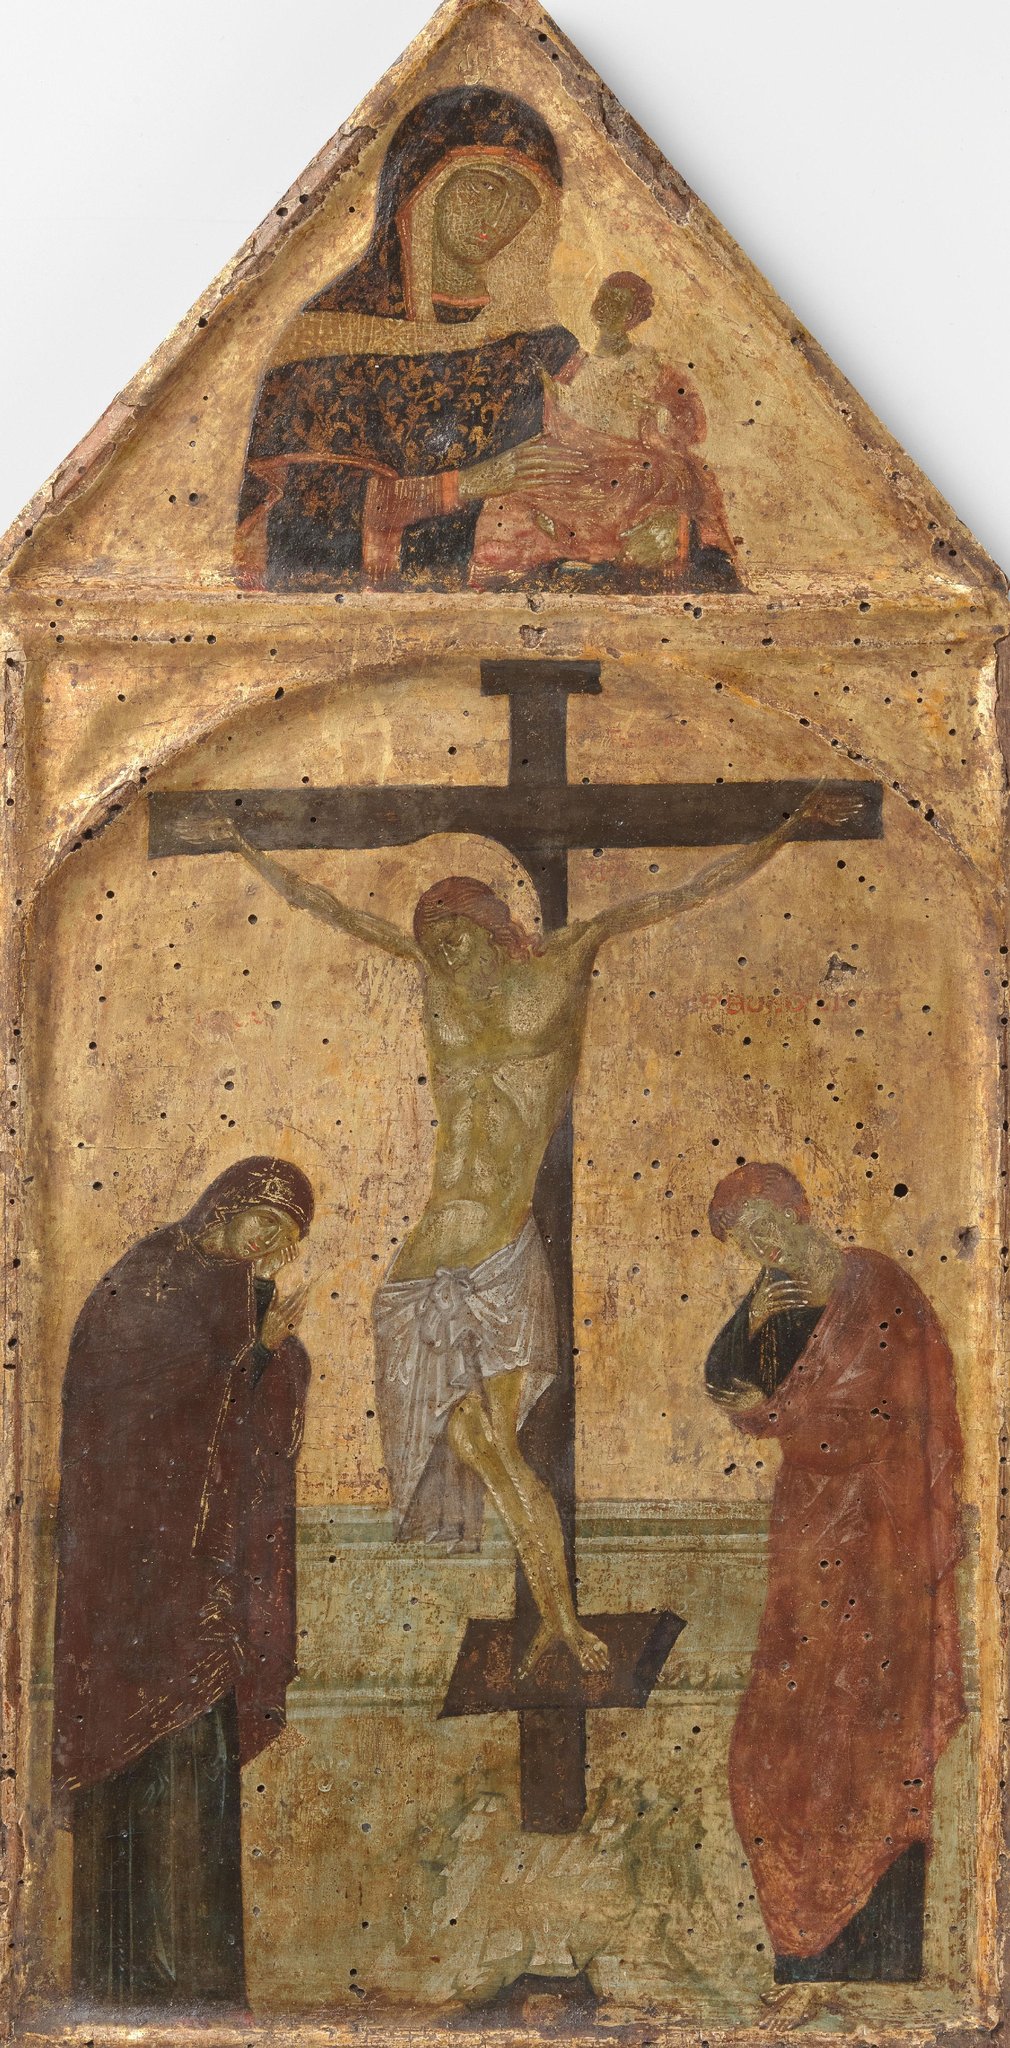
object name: painting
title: Christ on the Cross with Mary and John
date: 1250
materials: panel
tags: mary standing (or half-length), the christ-child on her arm (christ-child to mary's left), crucified christ with mary and john on either side of the cross; holy rood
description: This panel demonstrates the transition during the 13th century from the static imagery of Greek icon painting to a new expressive Italian style. It was painted either by a Greek (or Cypriot) artist in southern Italy, or by a southern Italian imitating the Greek style.